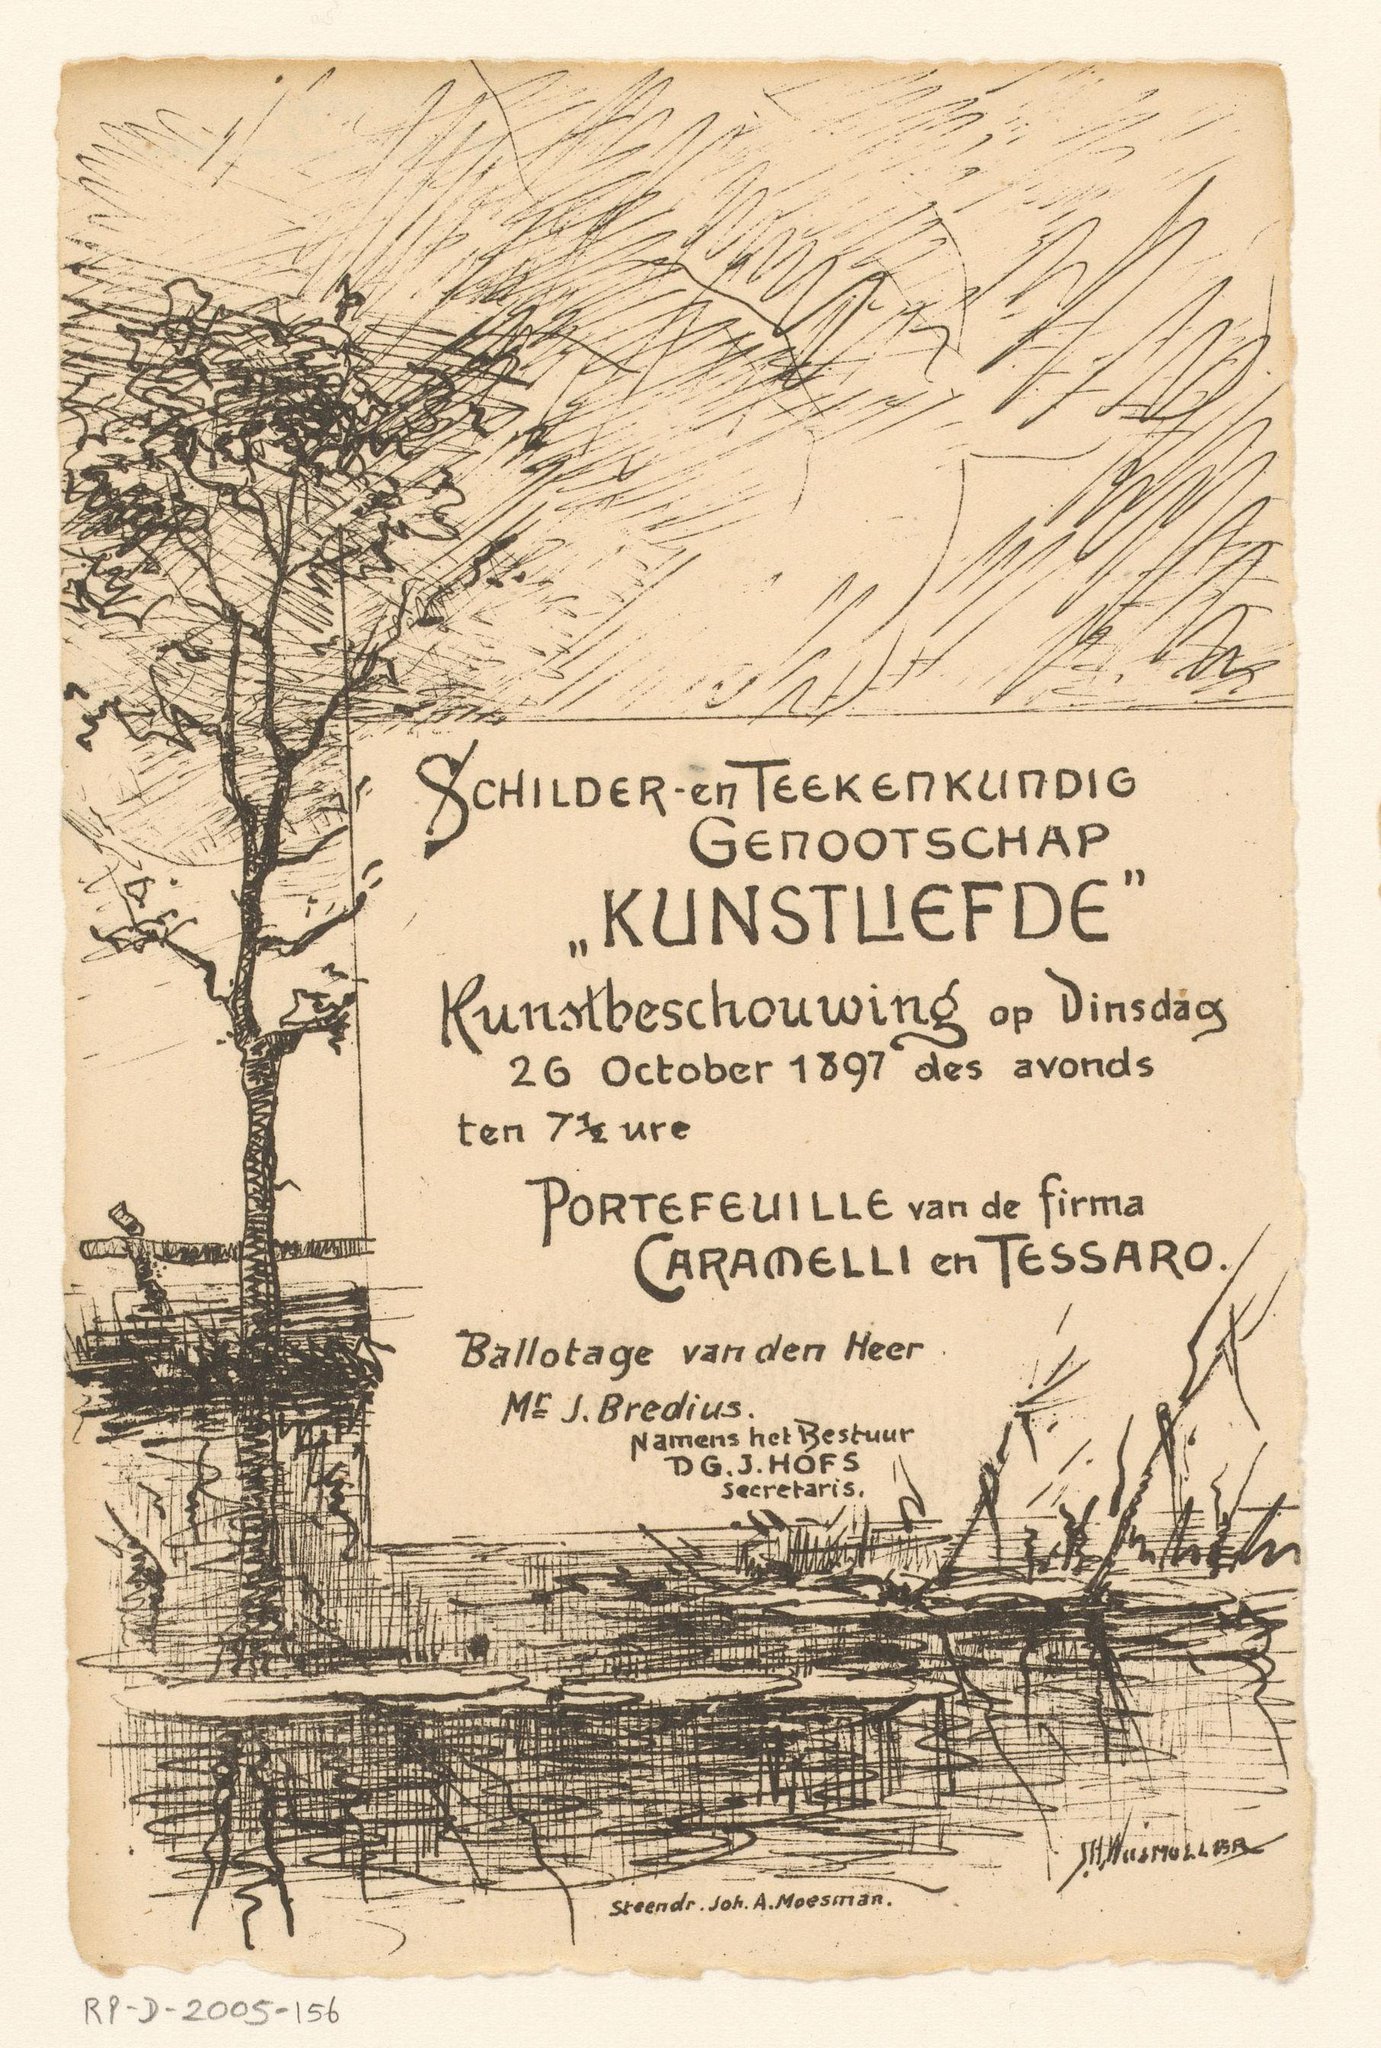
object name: invitation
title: Uitnodiging van Schilder- en Teekenkundig Genootschap "Kunstliefde" voor een kunstbeschouwing, 26 oktober 1897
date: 1810-1897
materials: paper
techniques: lithograph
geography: netherlands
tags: criticizing and discussing art, art criticism, circle, club of artists, collecting and exhibiting products of the fine arts, river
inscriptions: collector's mark: Lugt 2228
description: Waterlandschap. Uitnodiging van Schilder- en Teekenkundig Genootschap "Kunstliefde" voor een kunstbeschouwing op 26 oktober 1897 van de portefeuille van de firma Caramelli en Tessaro.